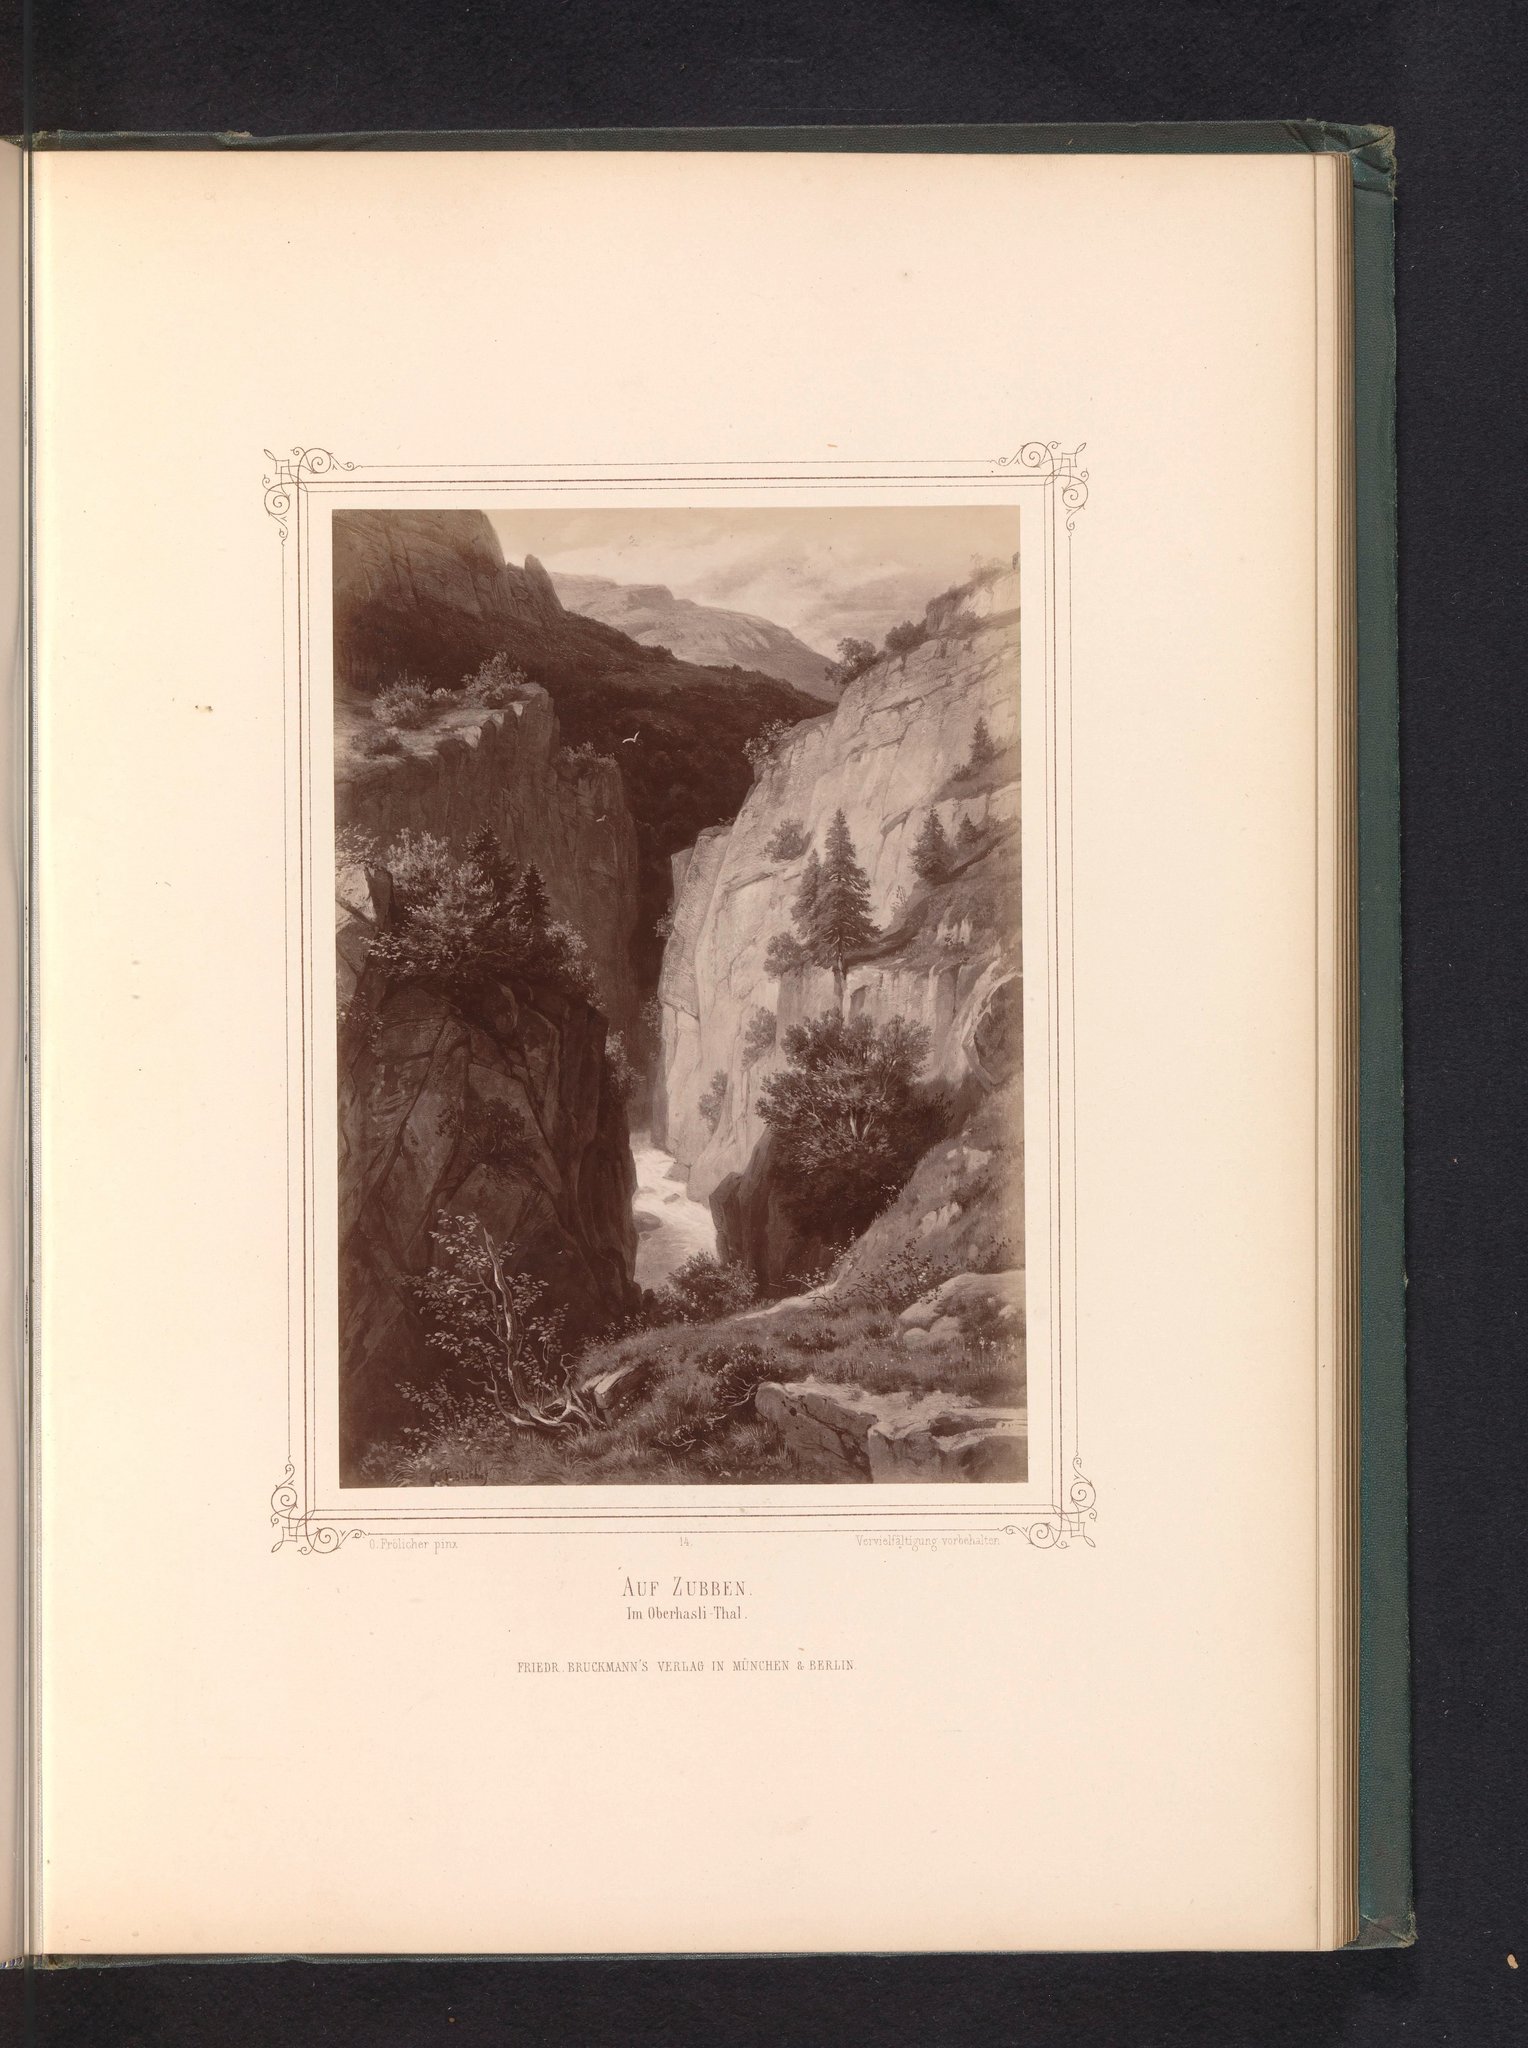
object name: photograph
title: Auf Zubben. Im Oberhasli-Thal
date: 1863-1873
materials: photographic support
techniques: albumen print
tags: river, ravine, chasm, abyss, canyon, mountains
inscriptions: number: ‘14.’